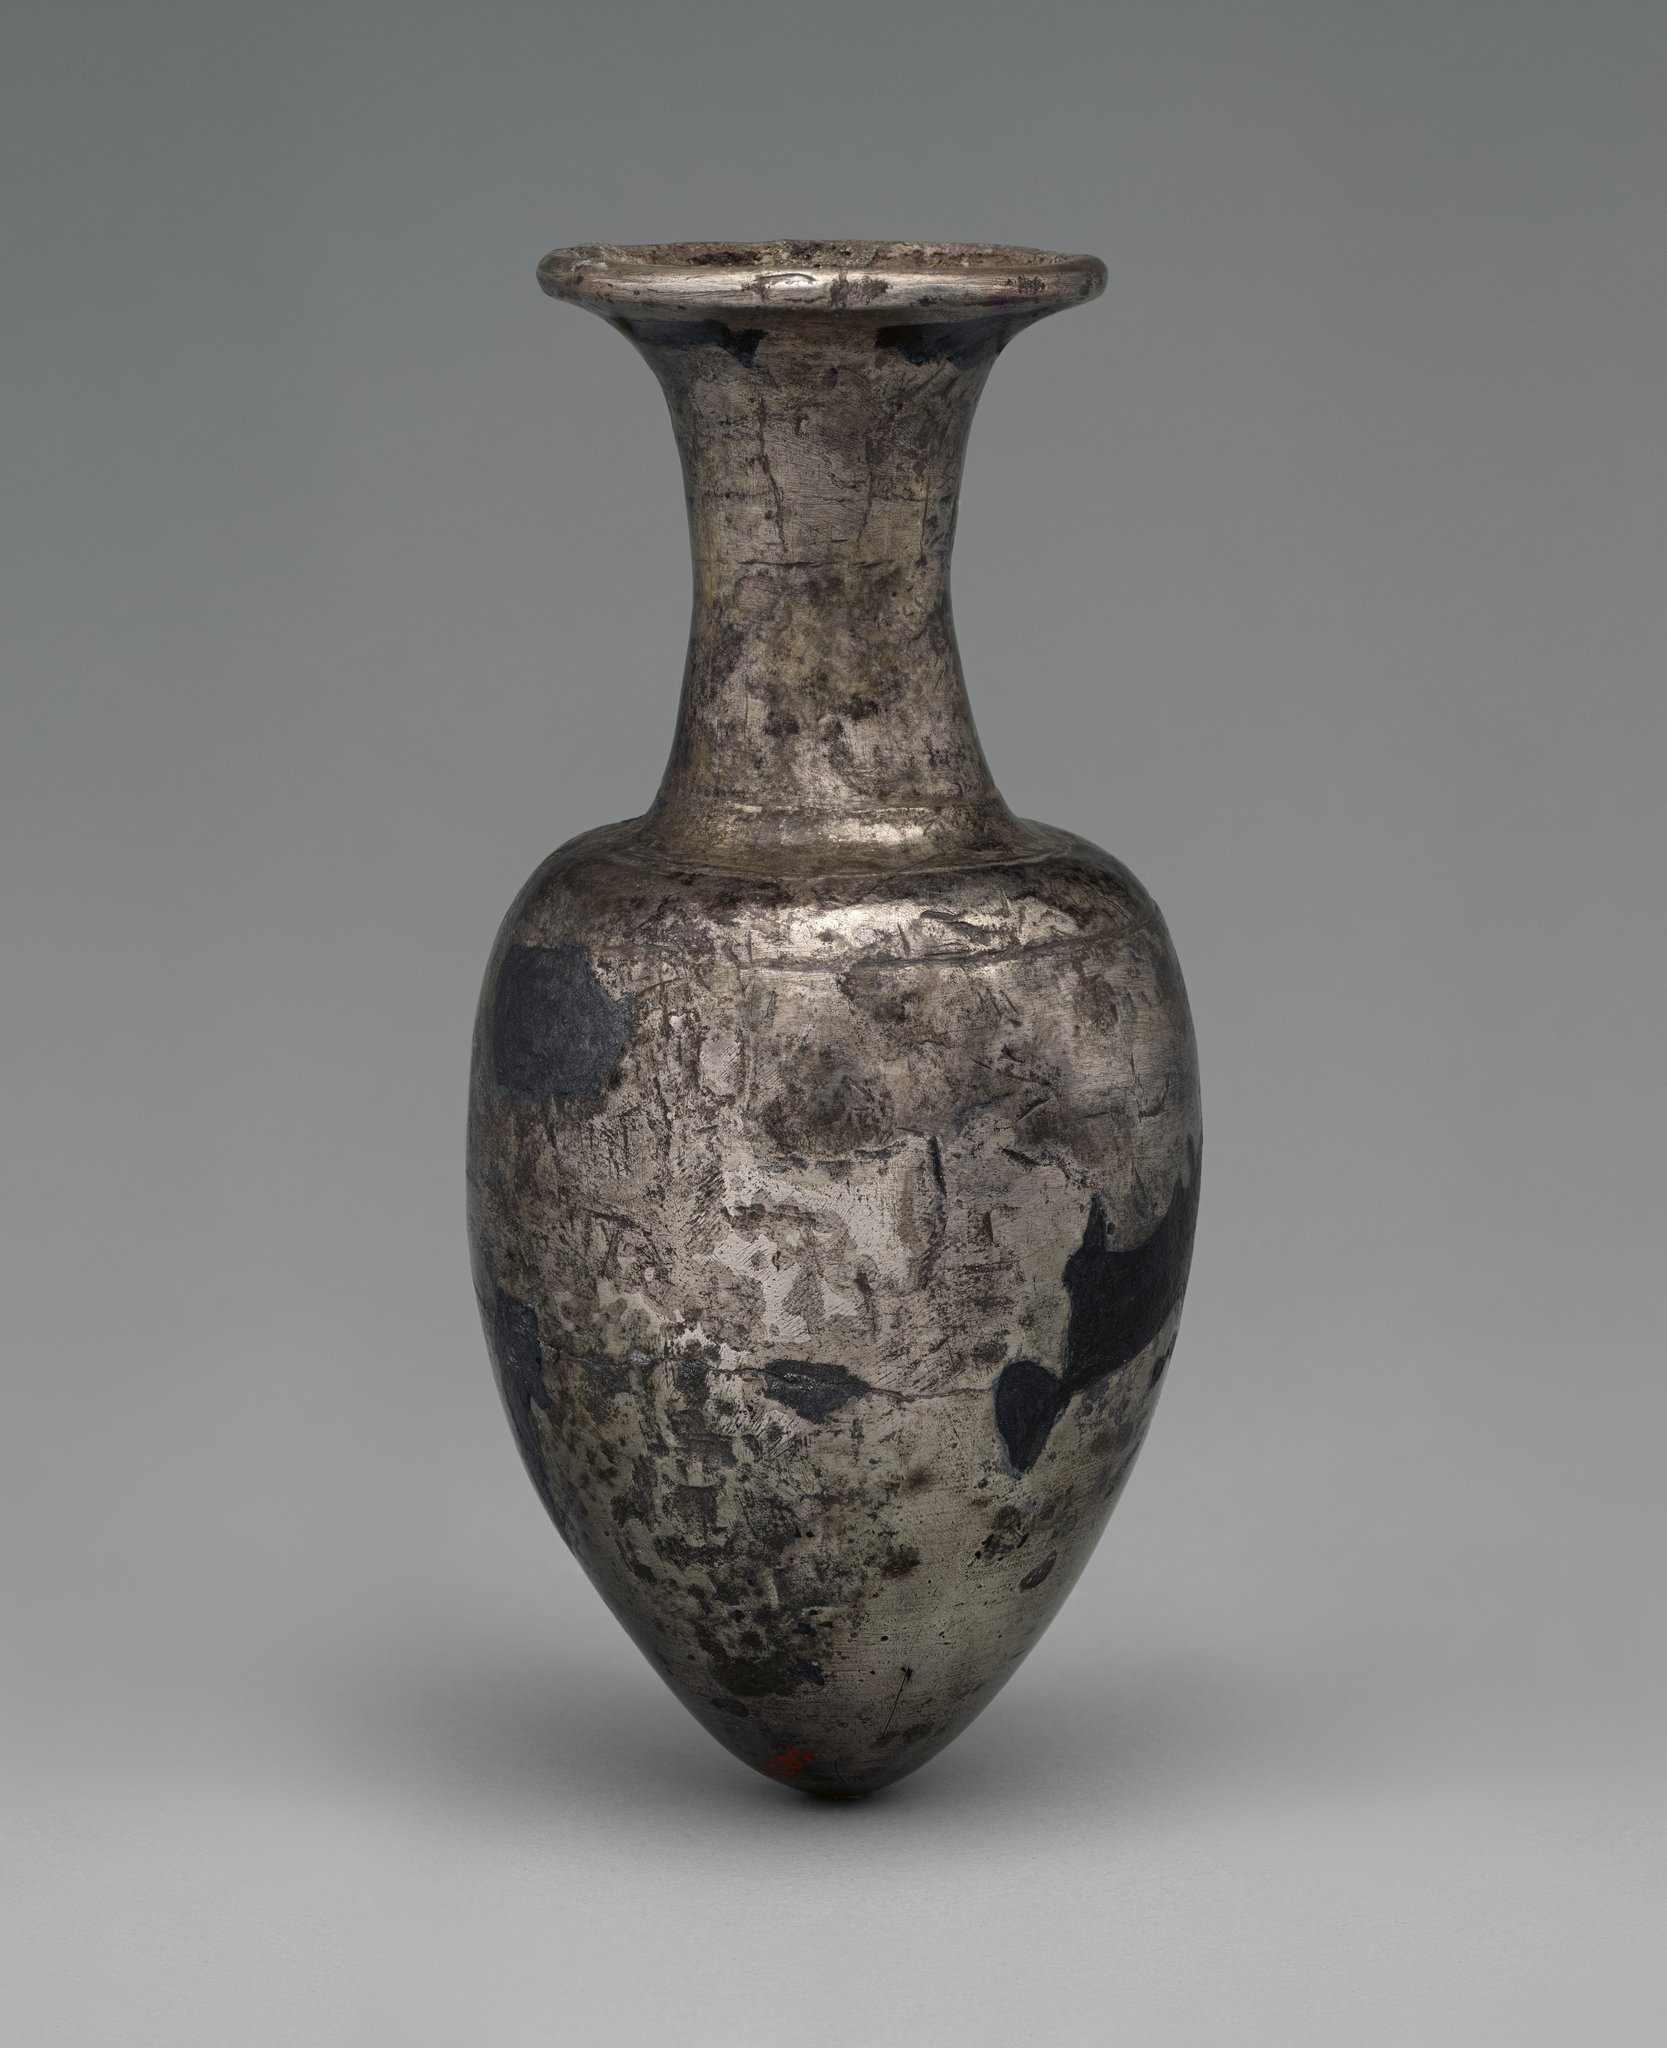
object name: jar, long necked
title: Long-necked jar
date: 1279-1213 BCE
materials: silver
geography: egypt